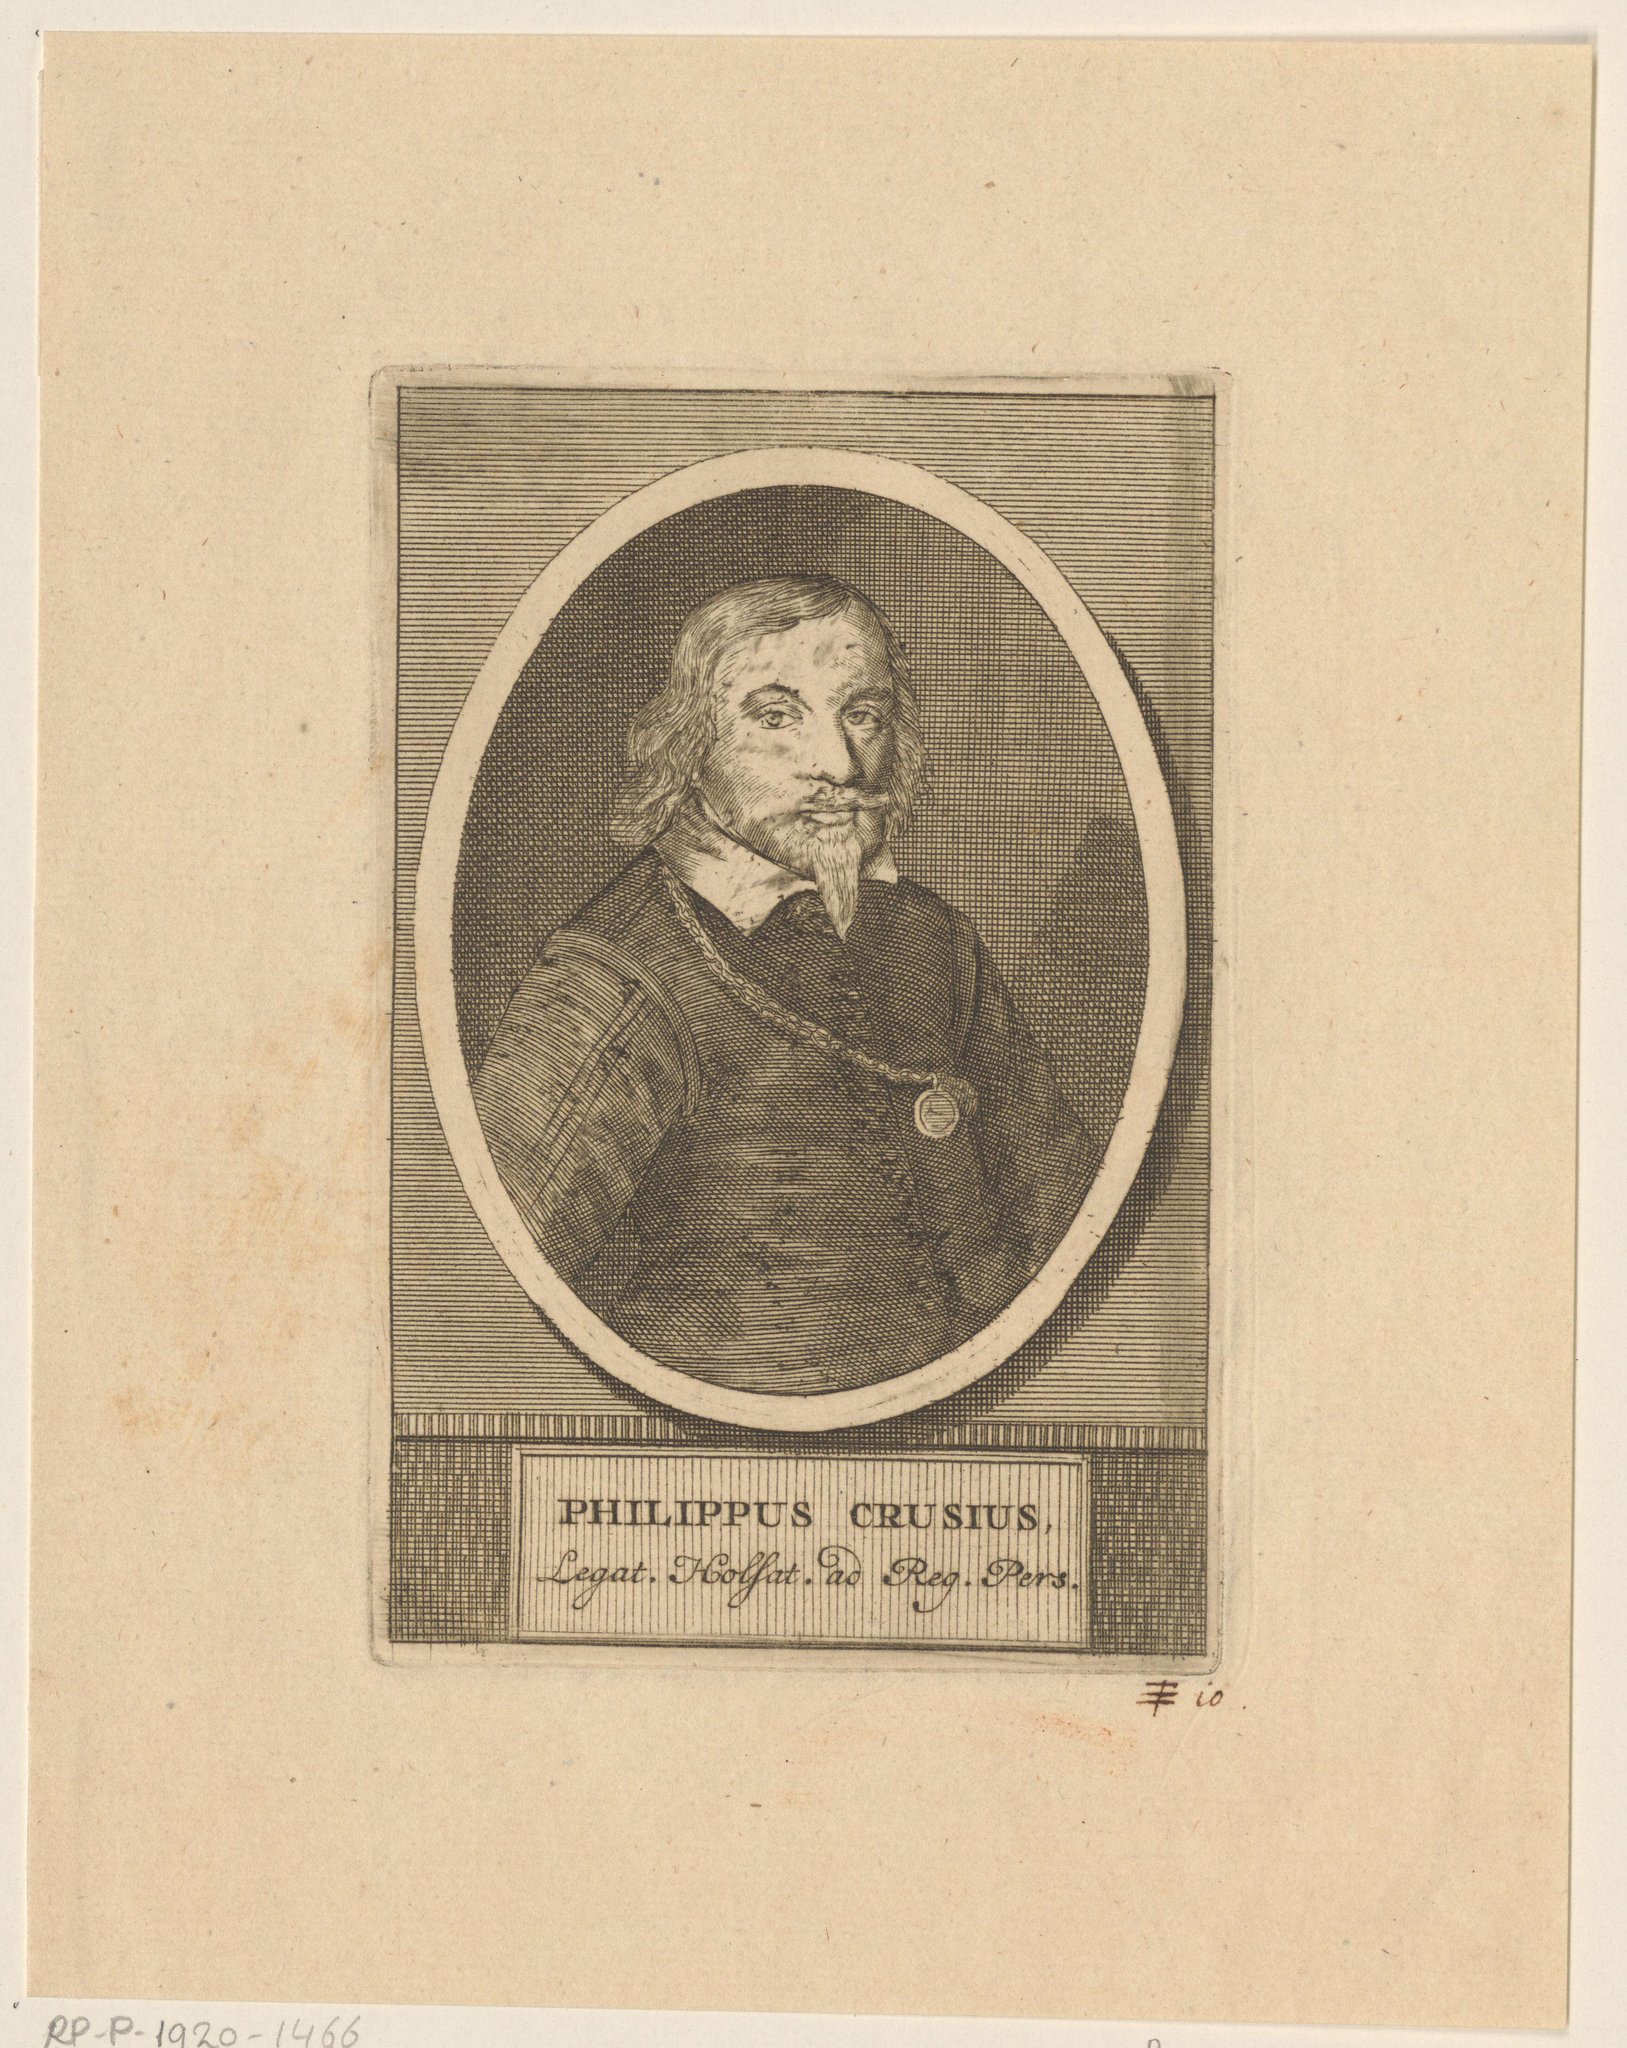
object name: print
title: Portret van Philipp Crusius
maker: Anonymous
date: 1668-1733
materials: paper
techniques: engraving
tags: politician, historical persons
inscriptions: collector's mark: Lugt 2228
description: Prent mogelijk uit: Imagines virorum celebriorum in politicis, historicis &c. Leiden: Pieter van der Aa (I), s.a.